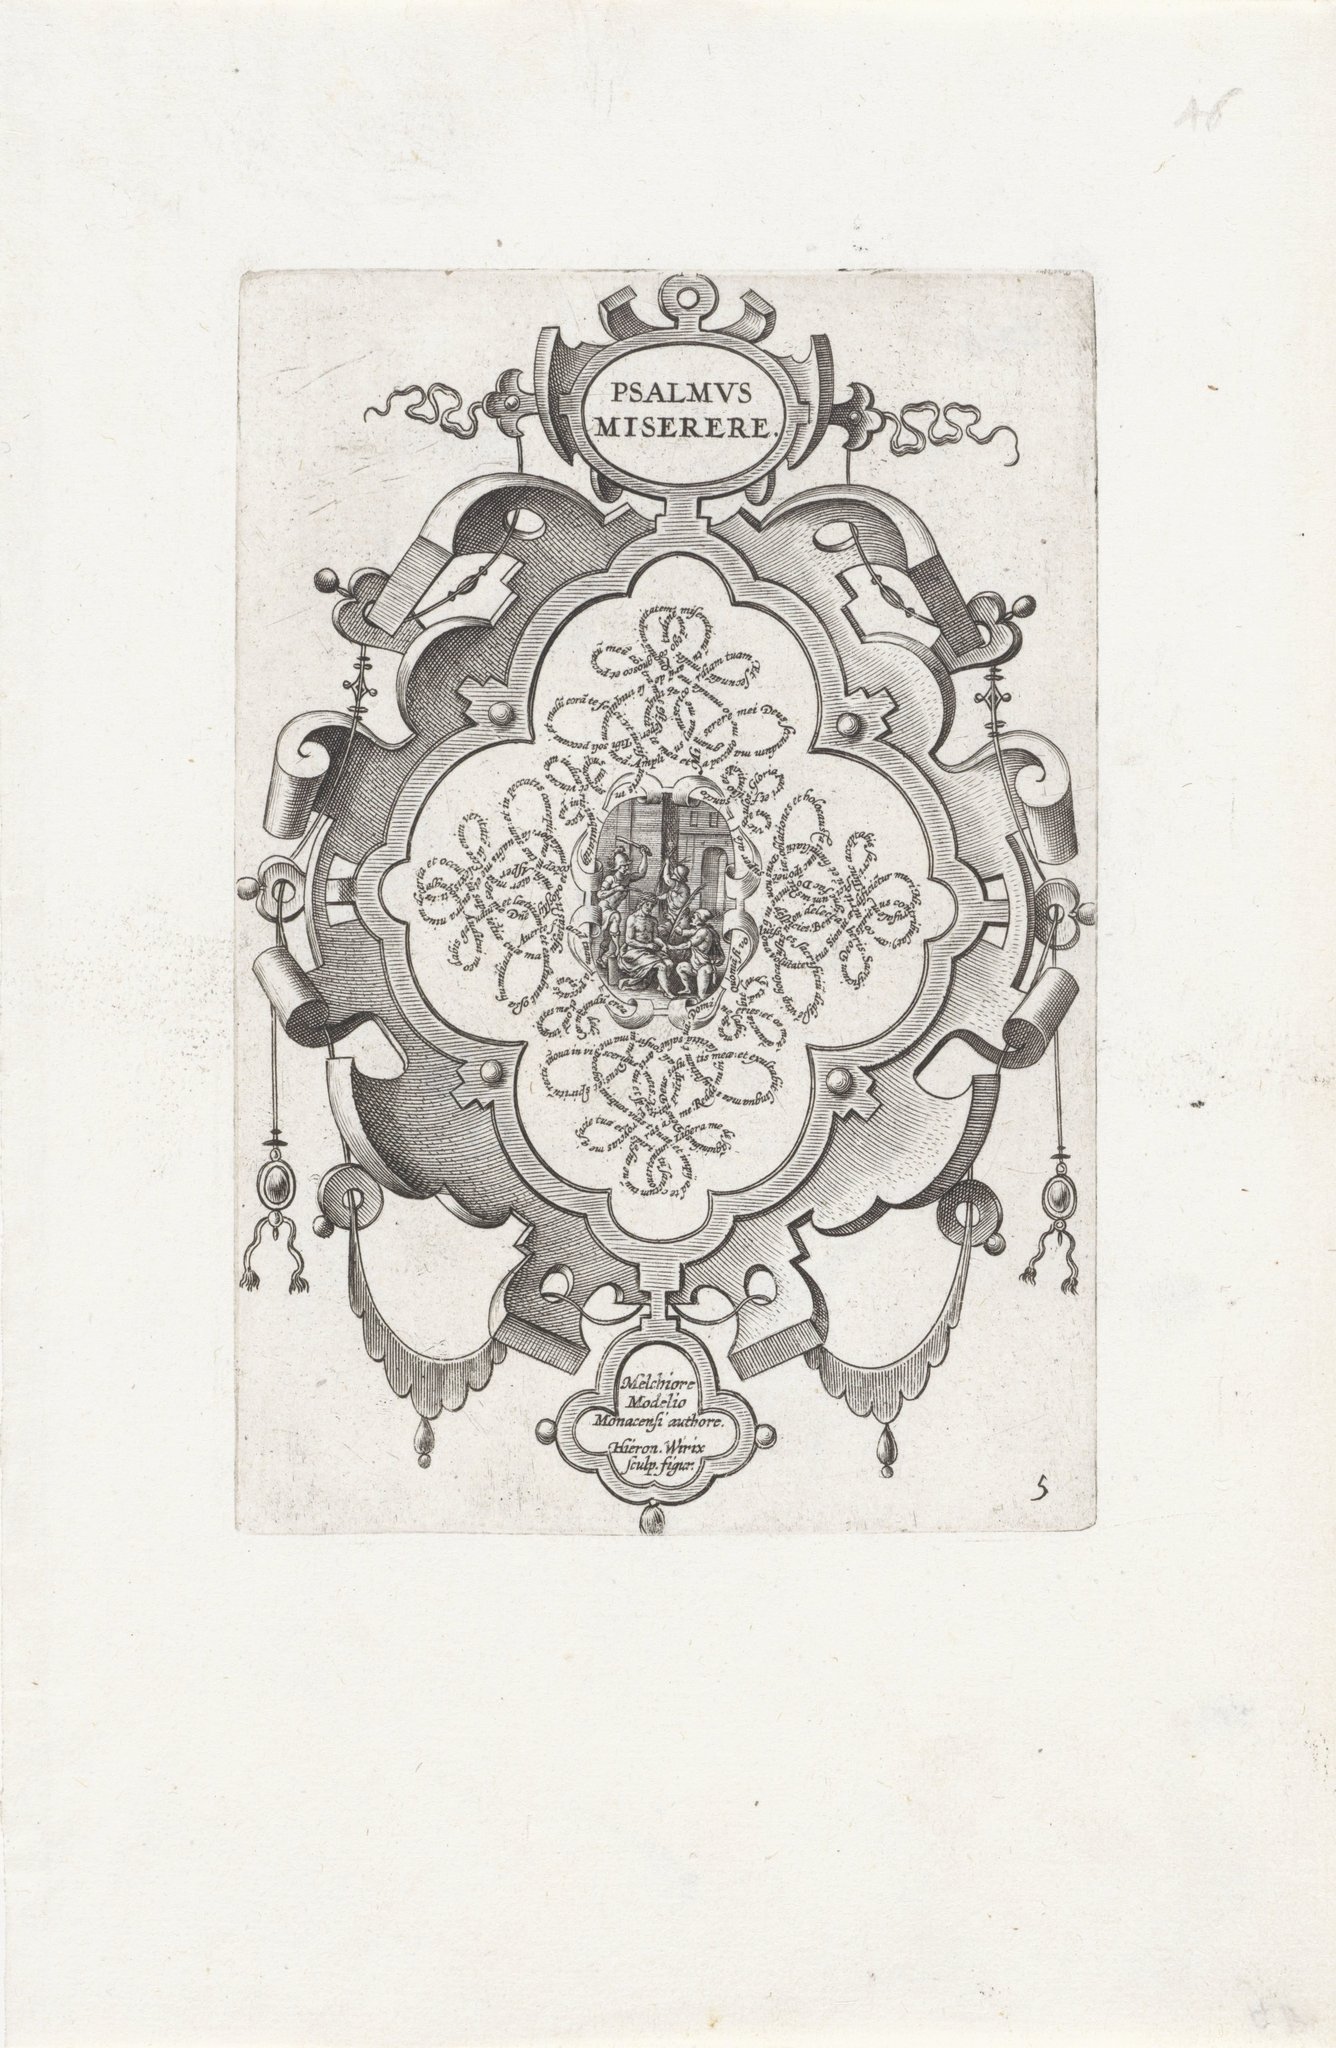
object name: print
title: Doornenkroning van Christus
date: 1608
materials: paper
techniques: engraving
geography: antwerp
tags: ornament ~ cartouche, the book of psalms, the crowning with thorns: soldiers with sticks place a thorny crown on christ's head and give him a reed (matthew 27:27-31; mark 15:16-20; john 19:2-3)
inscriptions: collector's mark: Lugt 2760, collector's mark: Lugt 2228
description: Twee soldaten duwen met stokken de doornenkroon op het hoofd van Christus. Een derde soldaat geeft hem de rietstengel. De voorstelling is gevat in een cartouche en geplaatst te midden van de in een knooppatroon gedrukte psalmtekst.